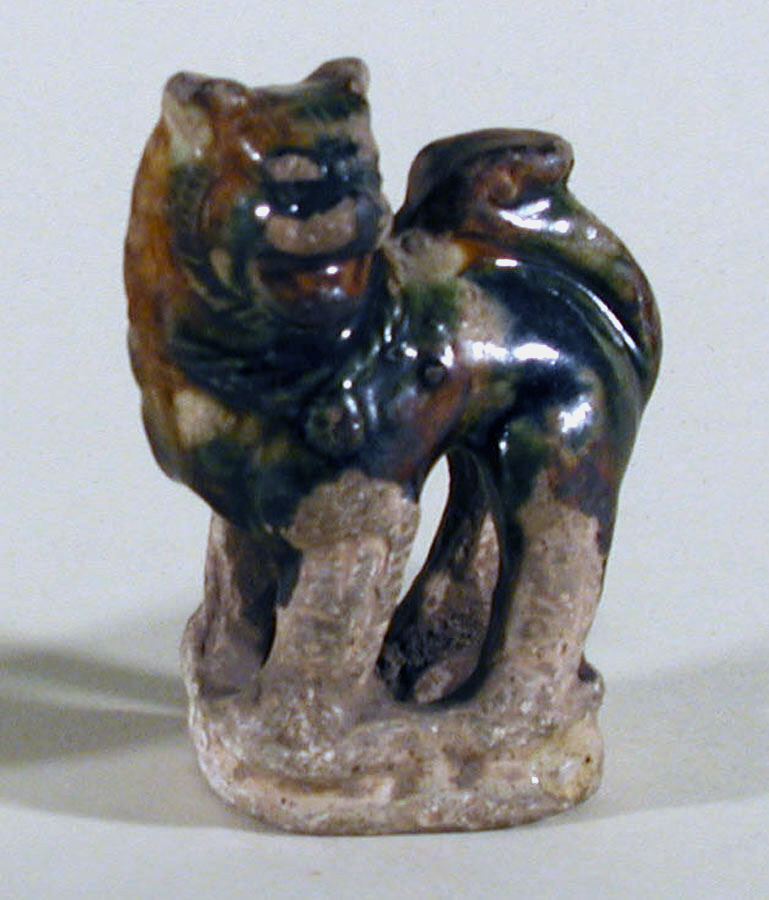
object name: figure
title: Lion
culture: chinese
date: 601-900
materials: clay, glaze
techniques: molding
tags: lions